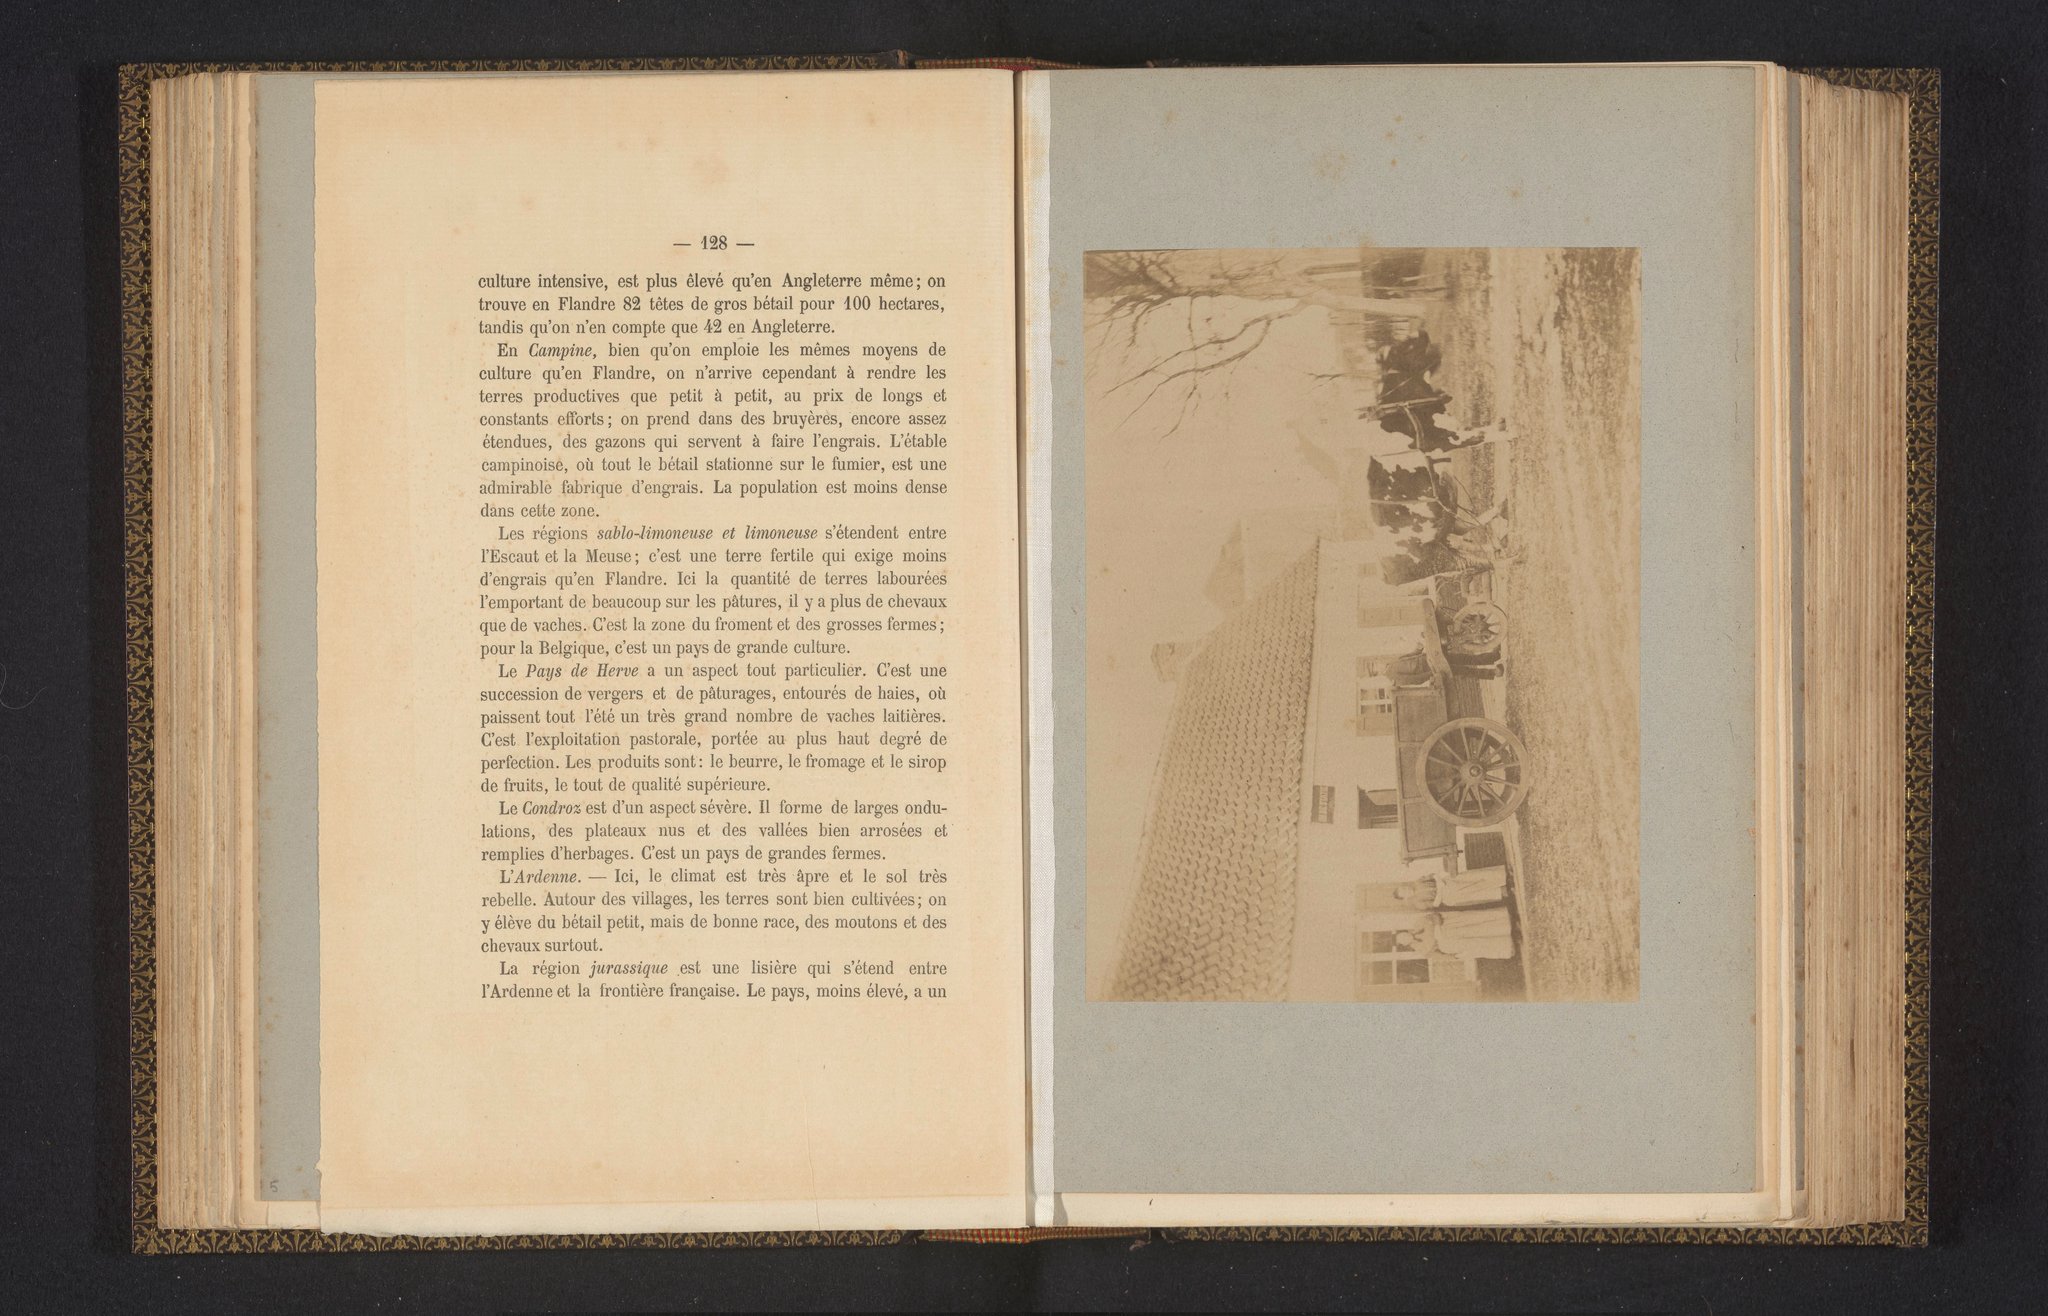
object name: photograph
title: Boer met een door een koe voortgetrokken kar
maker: Anonymous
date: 1888-1893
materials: photographic support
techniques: albumen print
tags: cow, farmers, two-wheeled vehicle drawn by one animal